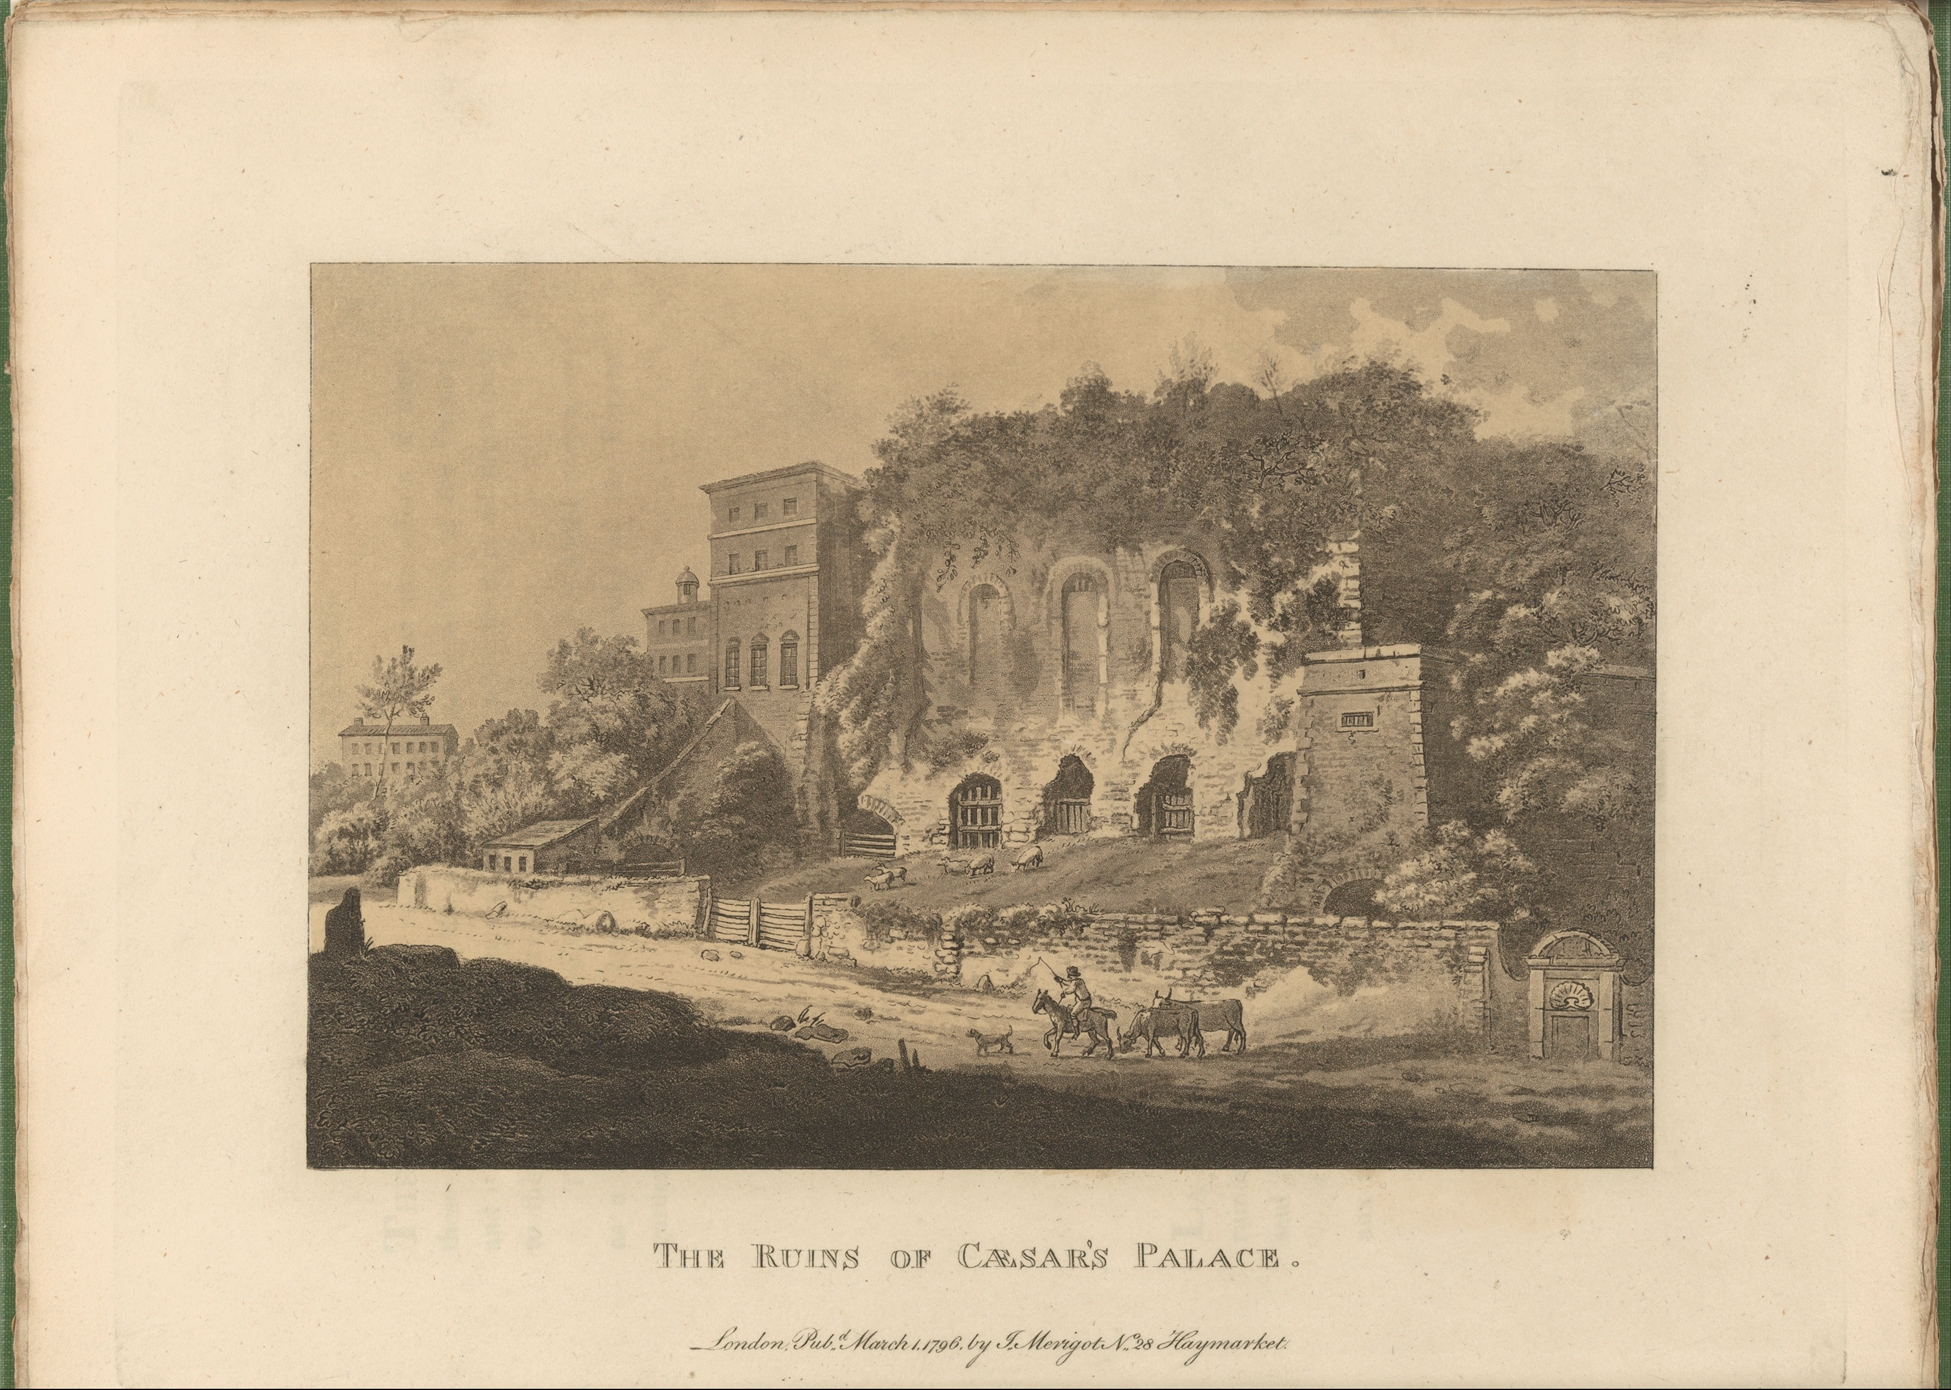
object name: book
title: A Select Collection of Views and Ruins in Rome and Its Vicinity. Recently Executed from Drawings Made Upon the Spot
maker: james merigot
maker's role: artist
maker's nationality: french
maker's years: 1760-1824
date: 1815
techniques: aquatint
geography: london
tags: animals,buildings,ruins,rome